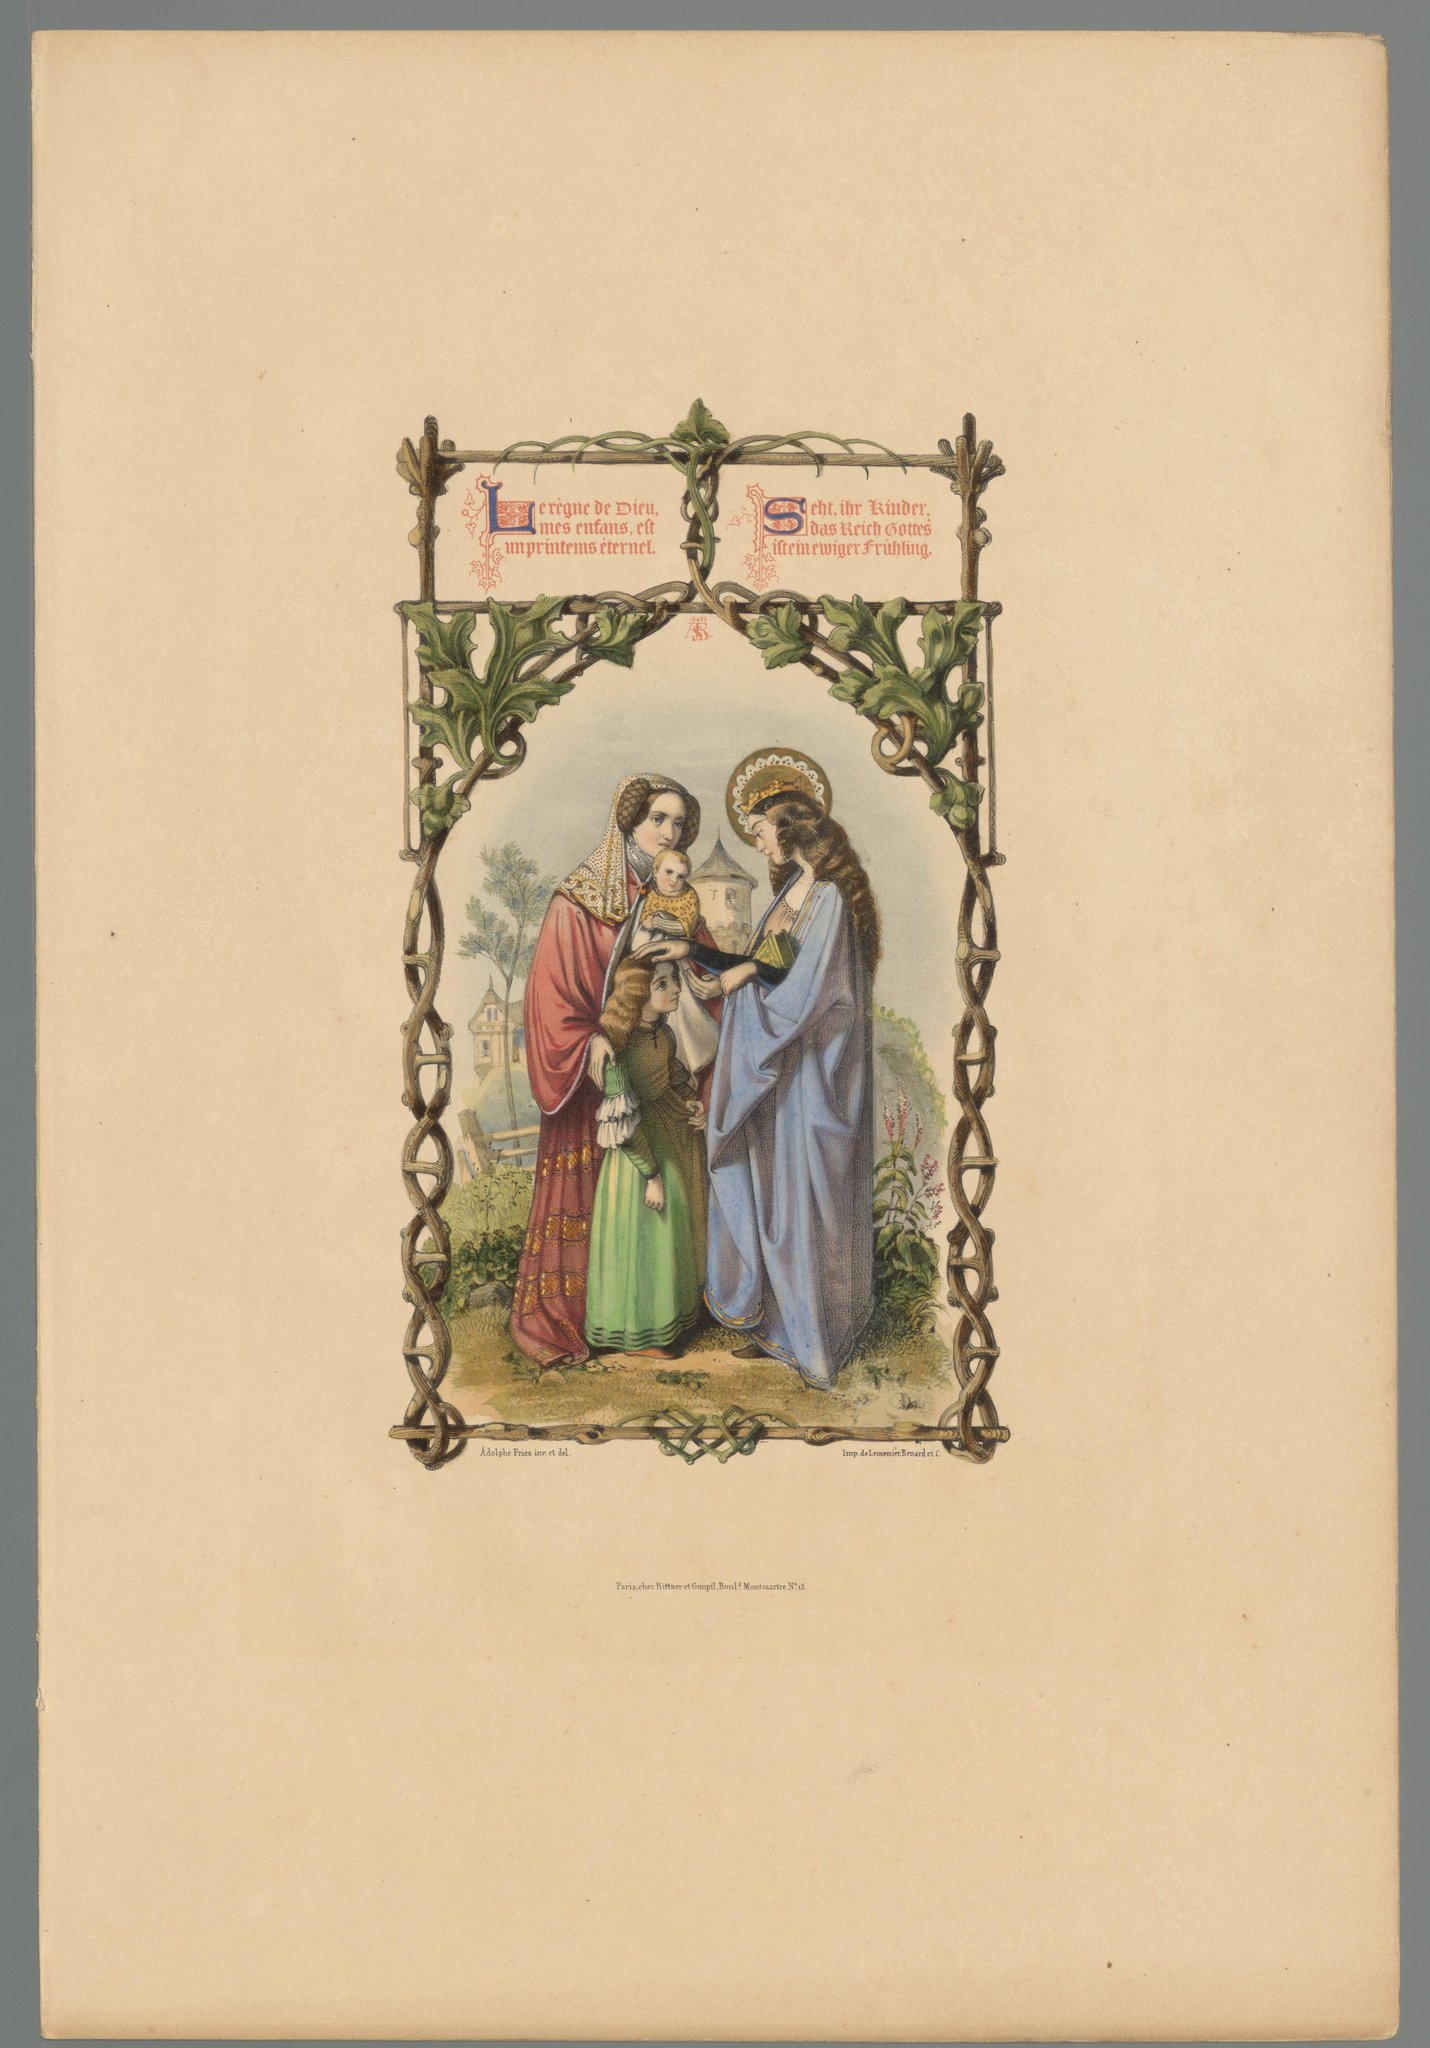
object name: print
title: Vrouw met twee kinderen bij een heilige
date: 1839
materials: paper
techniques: hand coloring, lithograph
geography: paris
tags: mother and child(ren), woman and child(ren) (family group), female saints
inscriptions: date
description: Prent maakt deel uit van een serie met religieuze scènes. Over deze serie is verder niets bekend. Mogelijk is het een aanvulling op de eerder uitgegeven serie 'Paroles de l'âme' van Adolf Fries in 1837.